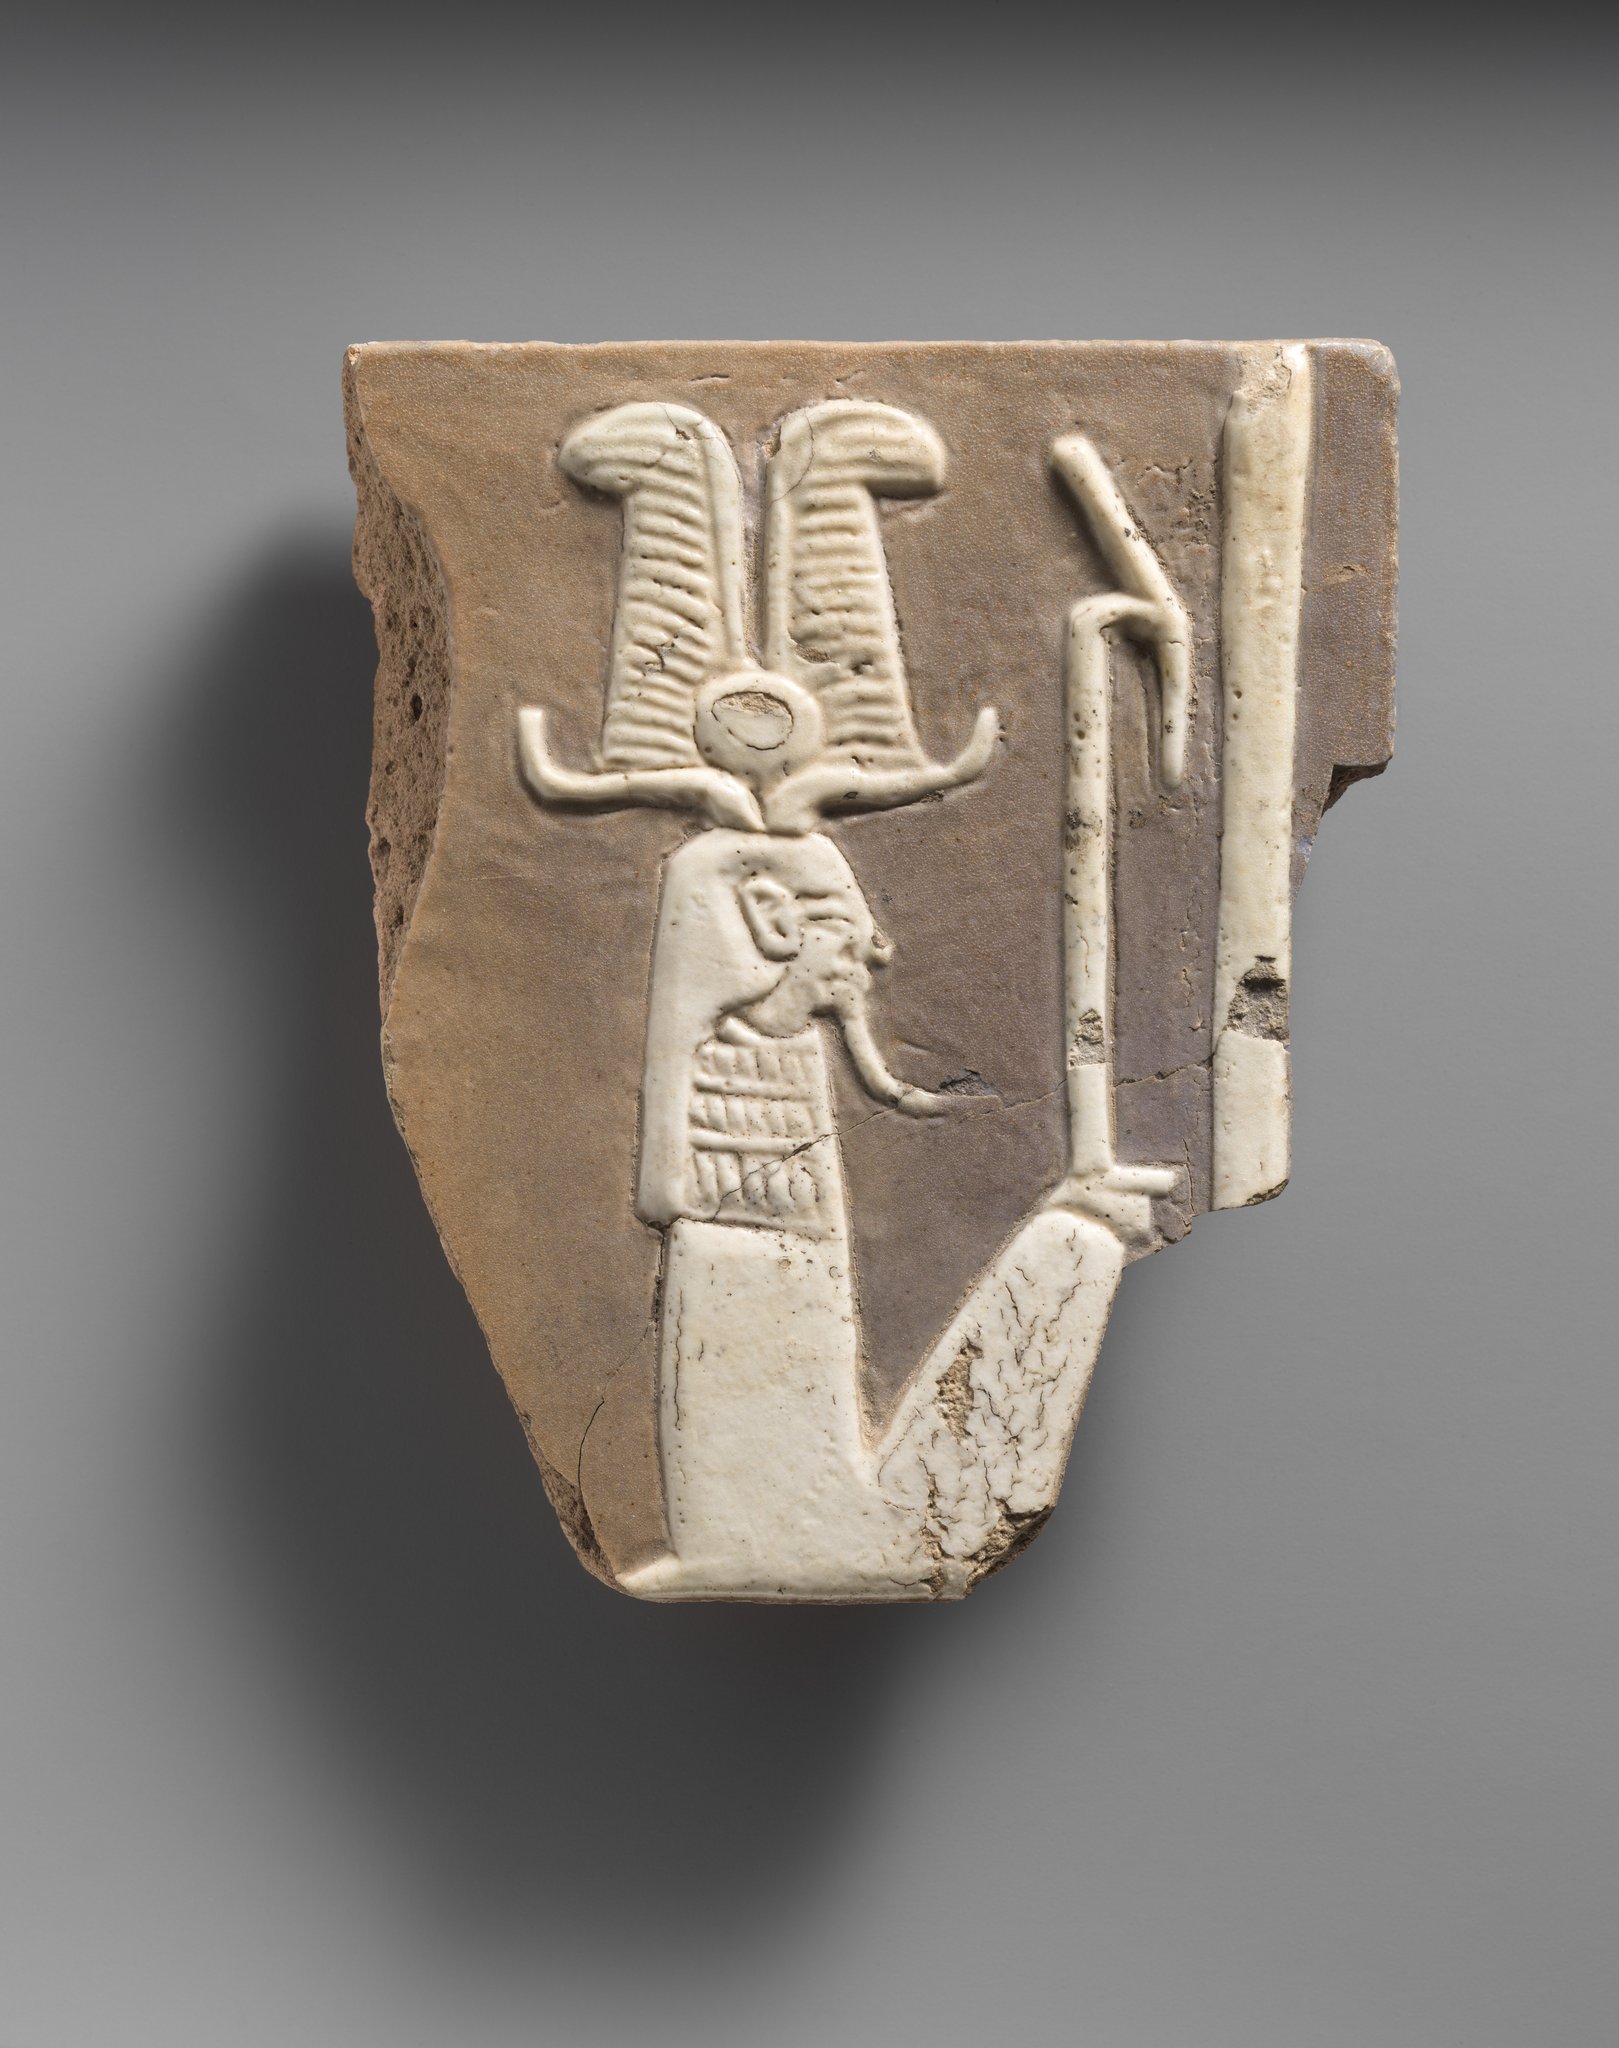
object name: tile fragment, ptah tatenen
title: Tile with seated Tatenen (or Ptah-Tatenen)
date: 1279-1213 BCE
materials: faience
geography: eastern delta